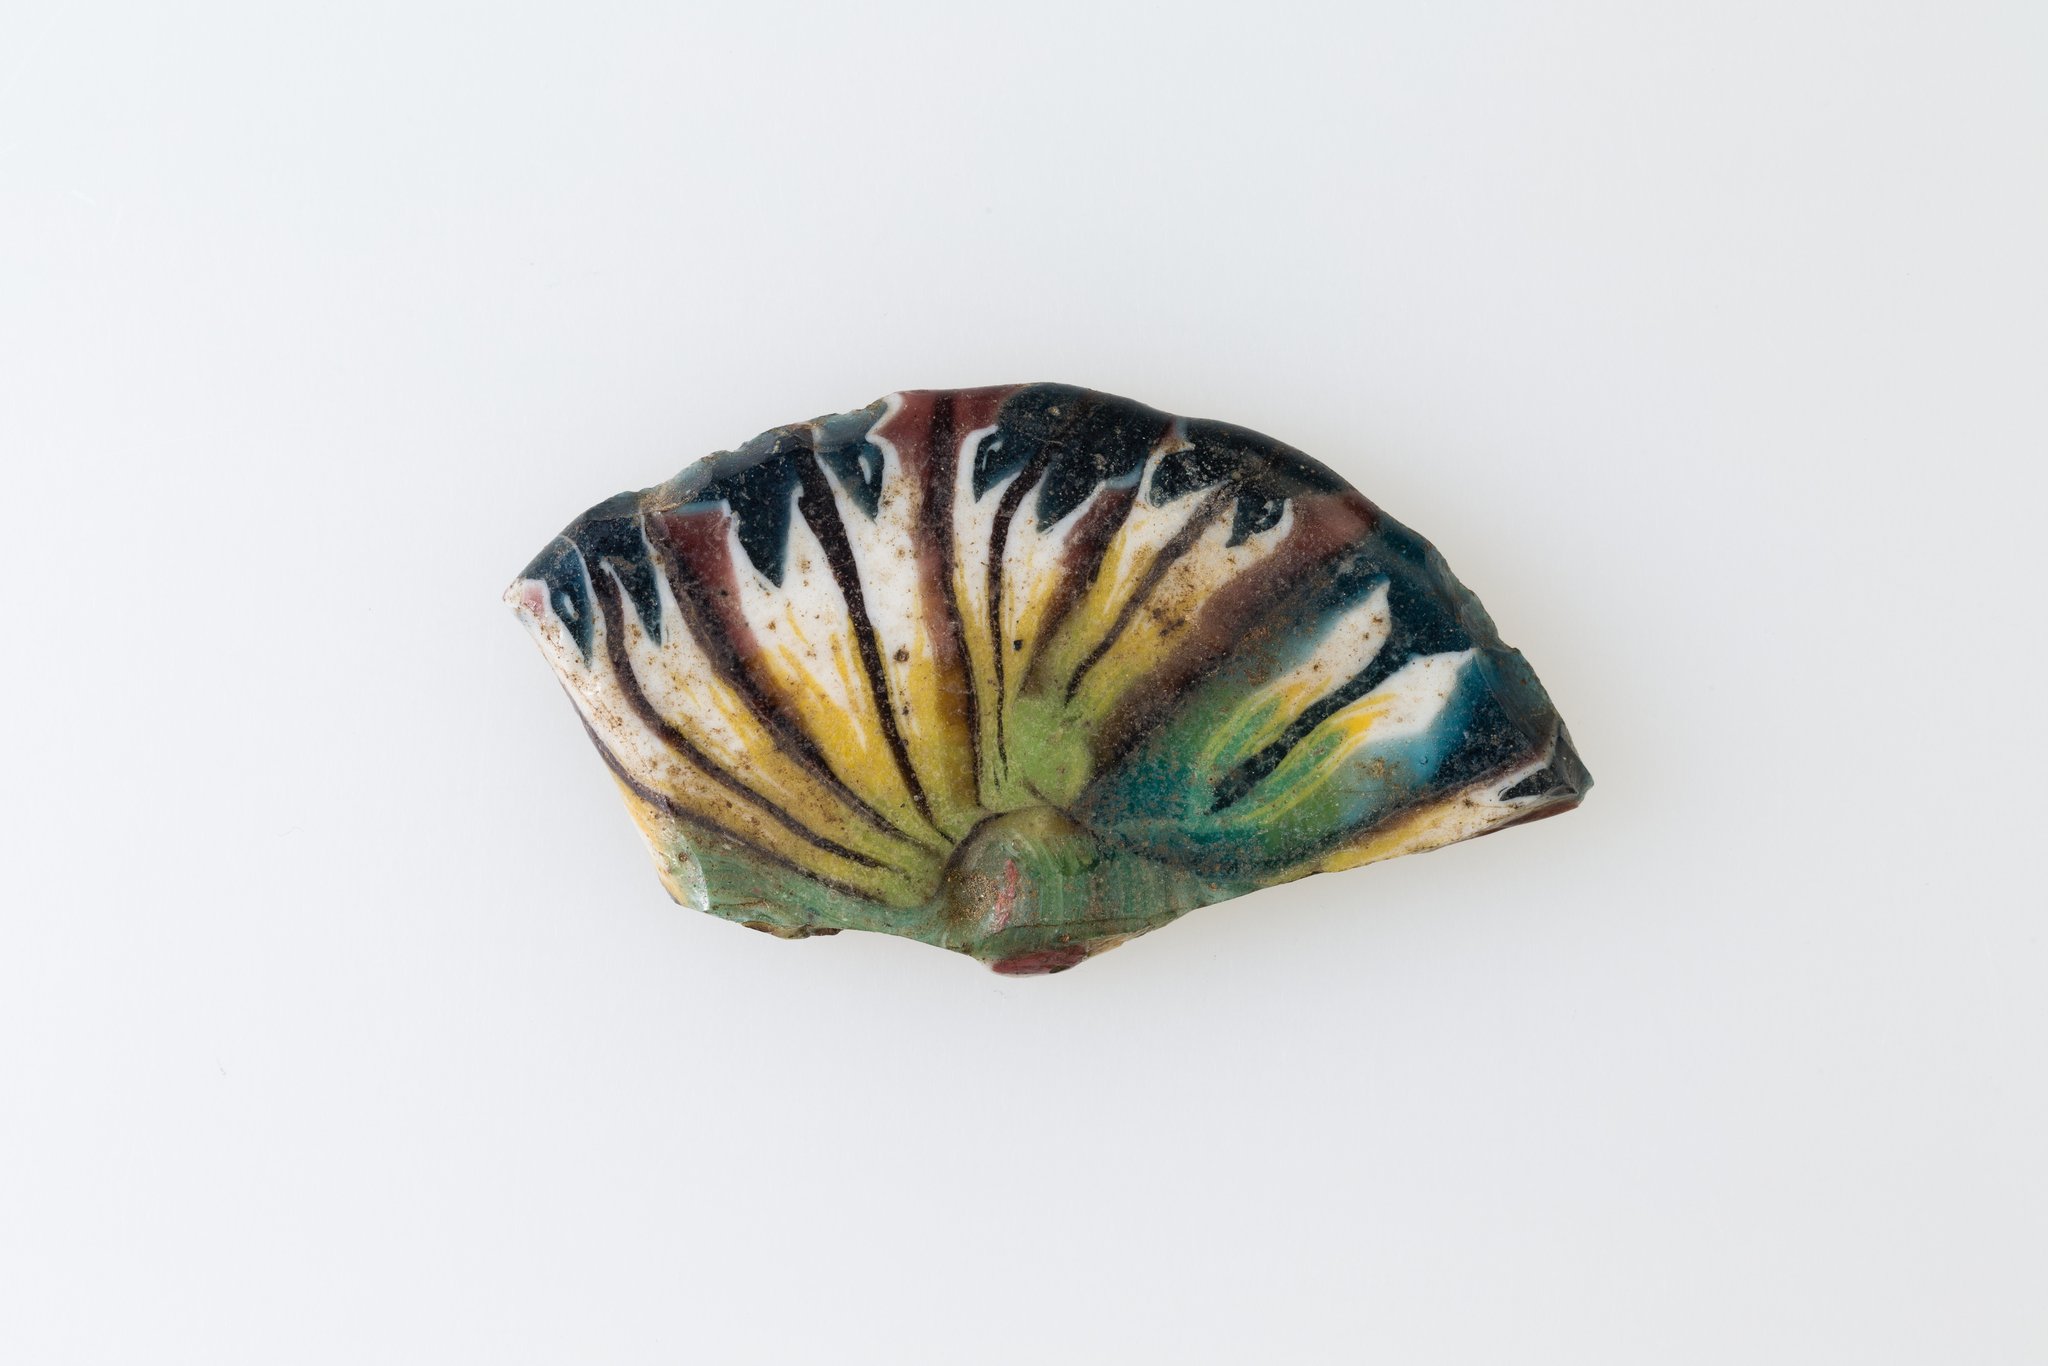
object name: glass fragment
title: Inlay, millefiori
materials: glass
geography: egypt